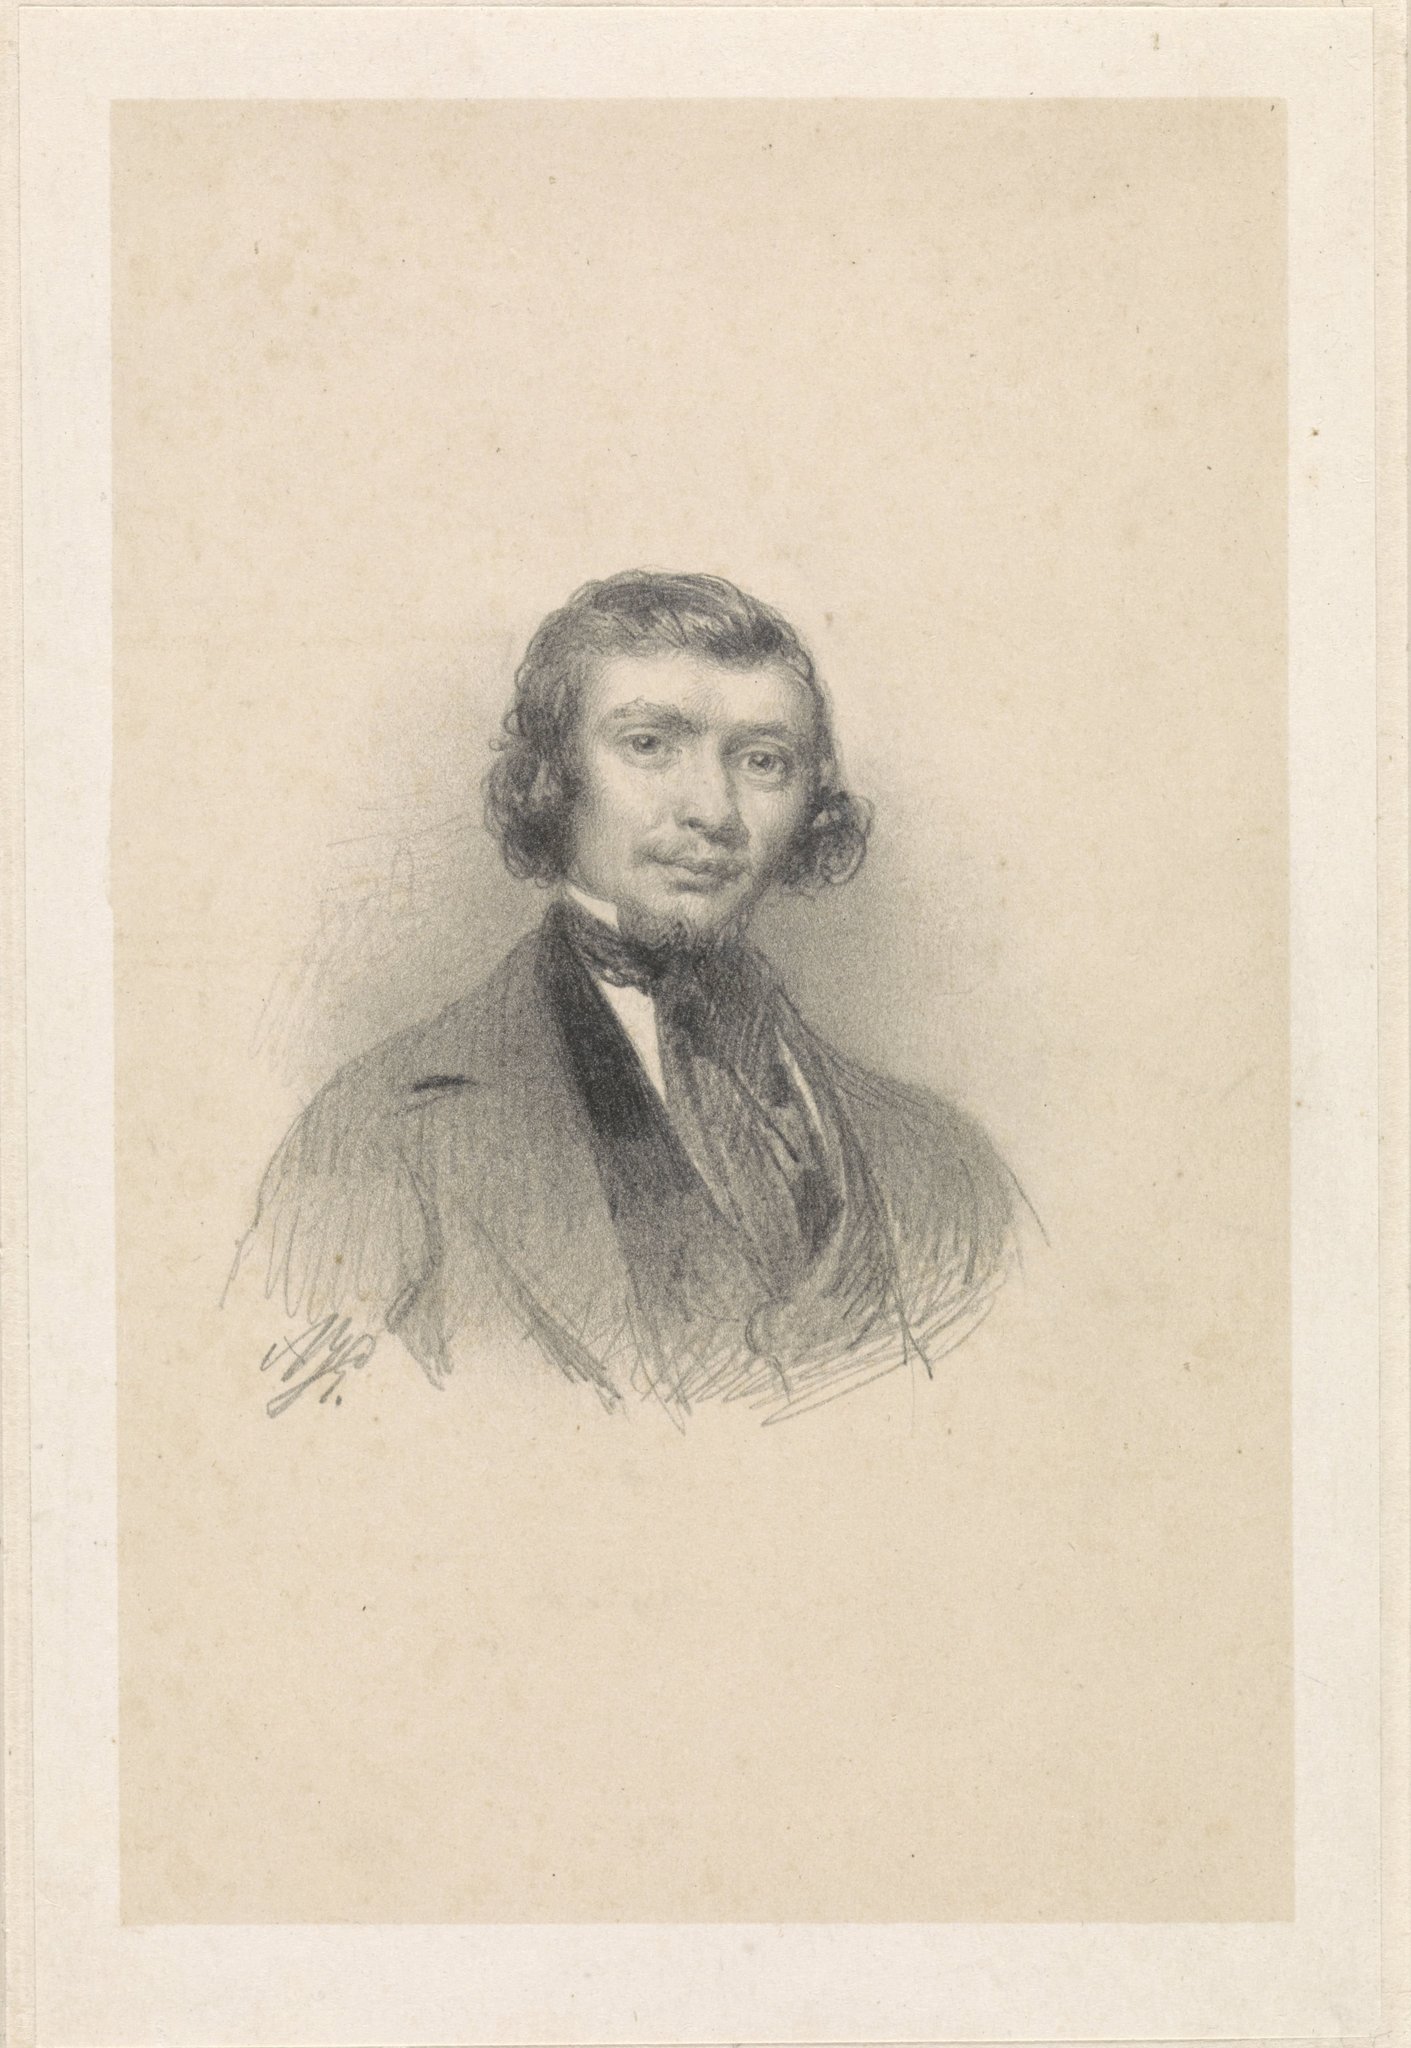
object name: drawing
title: Portret van David Joseph Bles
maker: adrianus johannes ehnle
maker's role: draughtsman, print maker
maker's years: 1819-1863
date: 1840-1863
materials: paper, pencil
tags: painter, david bles, historical persons, portrait, self-portrait of painter, portrait, self-portrait of artist, portrait, self-portrait of draughtsman